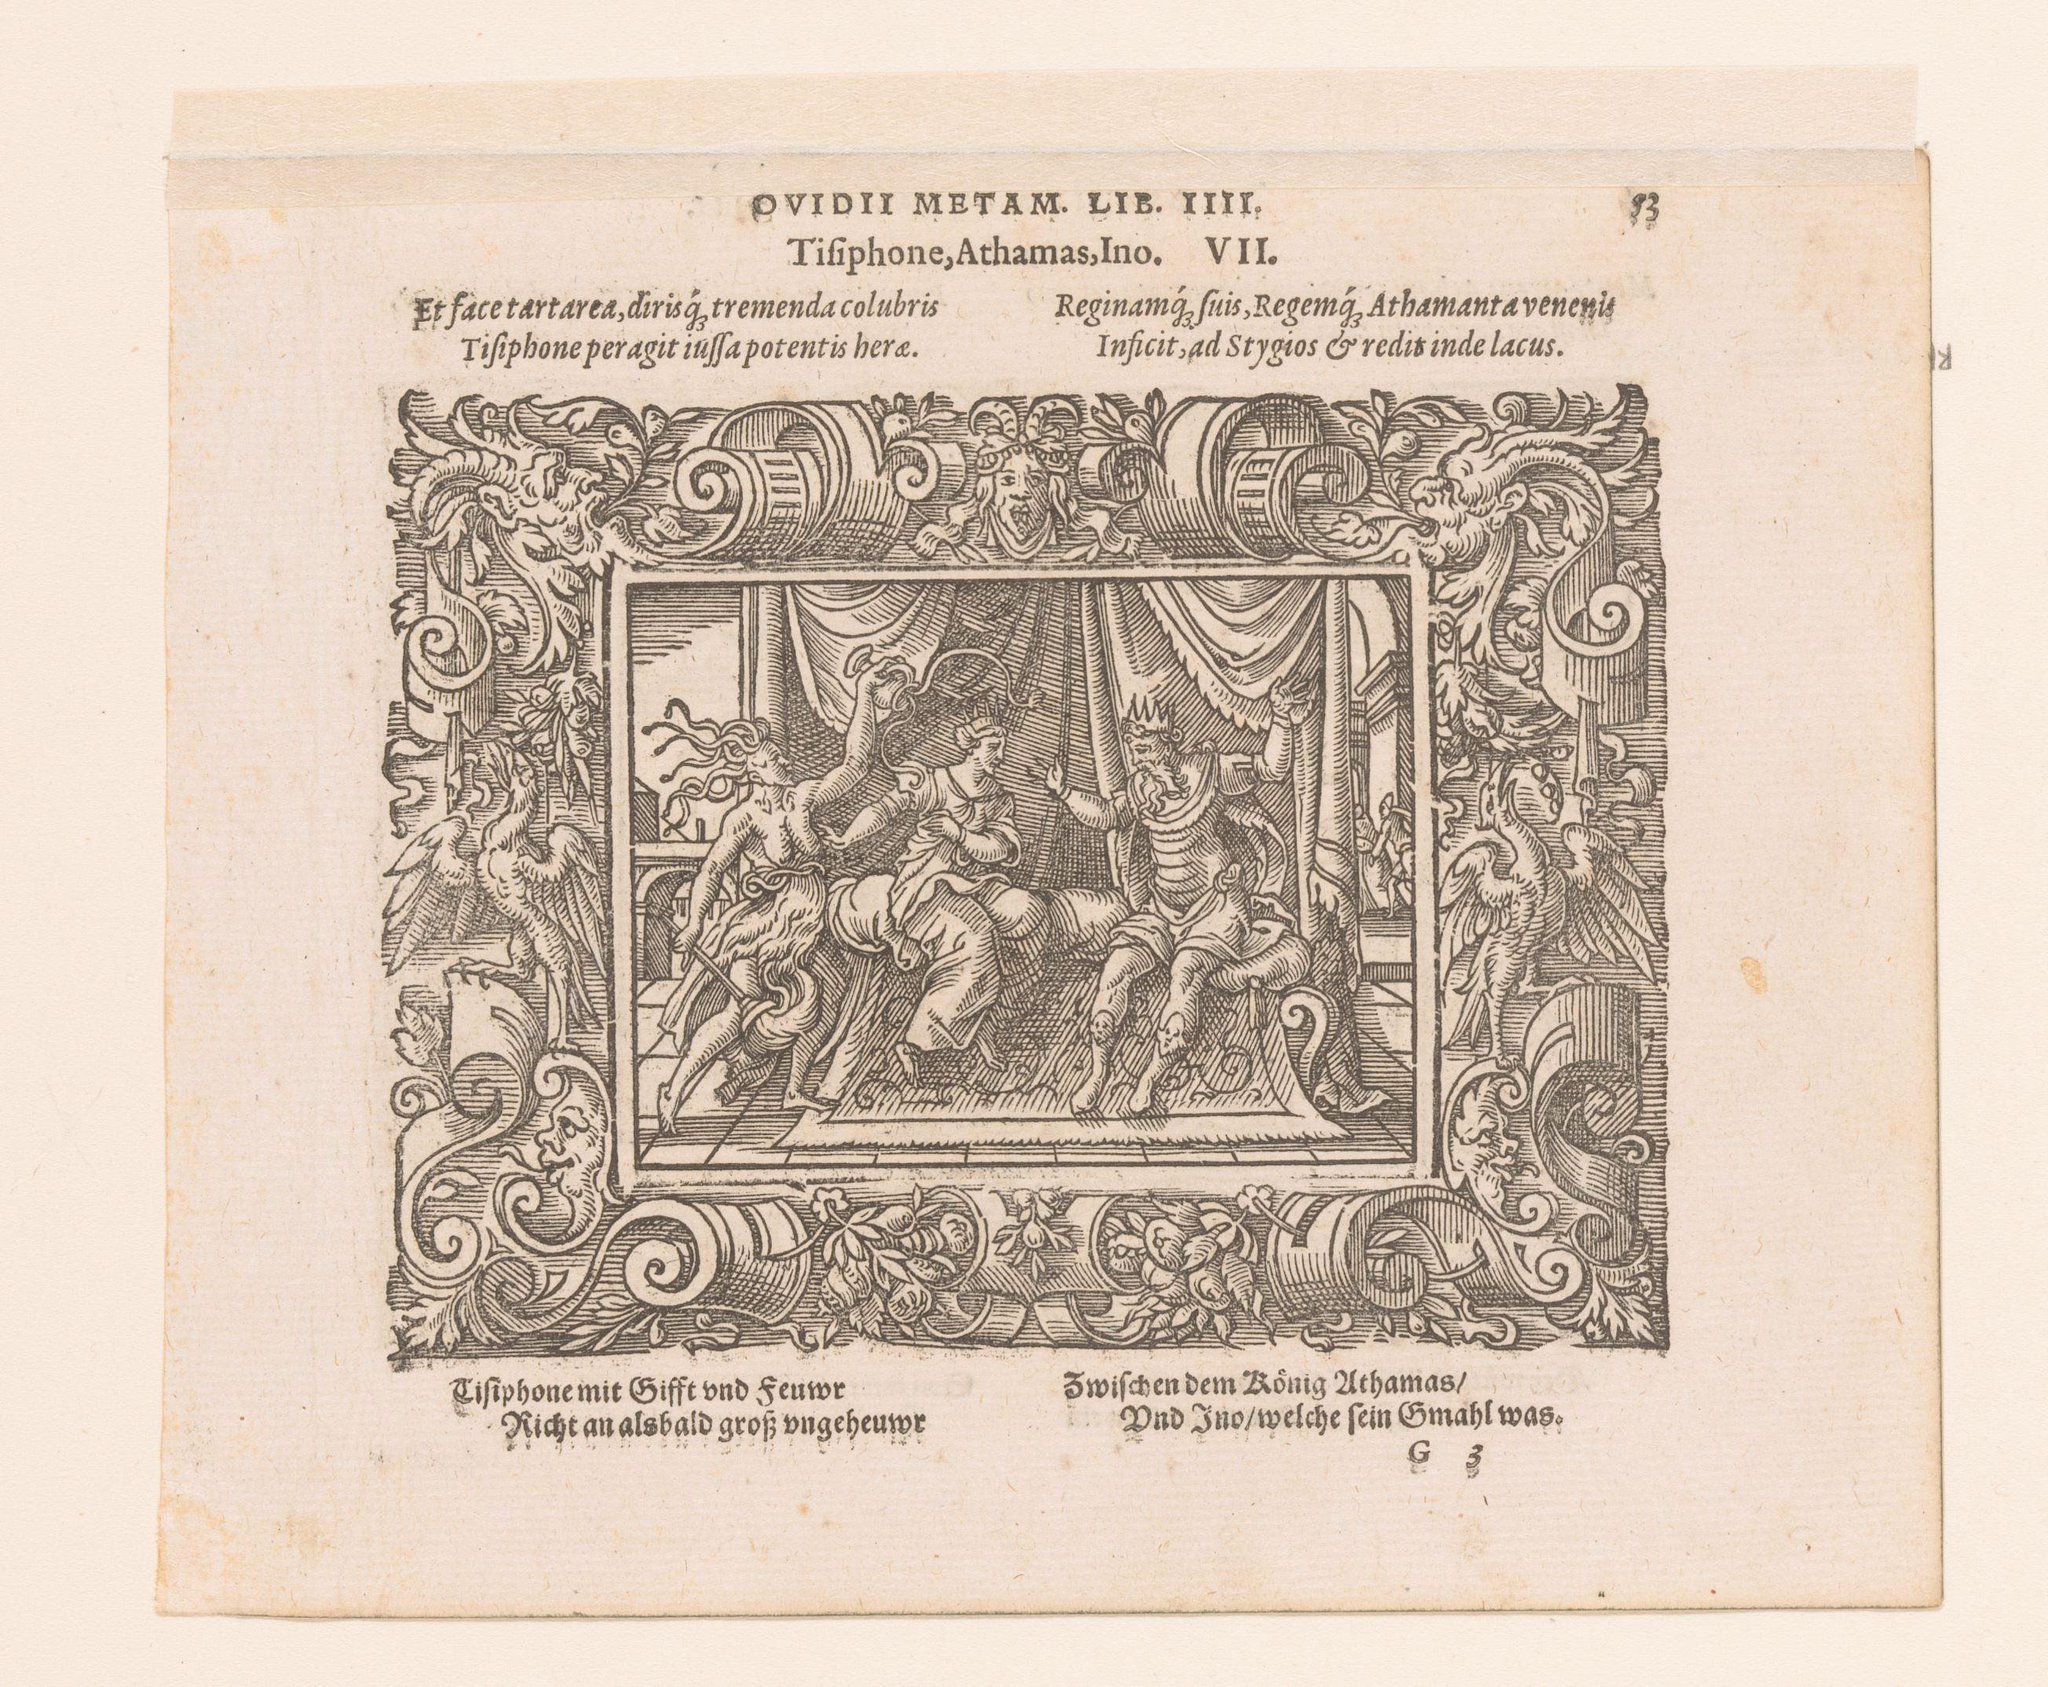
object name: print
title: Wraakgodin Tisiphone neemt wraak op Athamas en Ino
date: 1569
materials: paper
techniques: letterpress printing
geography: frankfurt am main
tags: athamas is driven mad by tisiphone, one of the furies, sent by juno, scrollwork, strapwork ~ ornament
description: Illustratie bij de Metamorfosen van Ovidius, afkomstig uit de publicatie: Posthius, Johannes. Tetrasticha in Ovidii metam. Frankfurt am Main: Georg Rab en Sigmund Feyerabend en erven Weigand Han, 1569. De voorstellingen en ornamentranden van deze boekillustraties zijn van twee aparte blokken gedrukt. Beide werden afzonderlijk van elkaar ook gebruikt voor andere publicaties, en de ornamentranden werden eveneens binnen deze publicatie meerdere keren gebruikt.